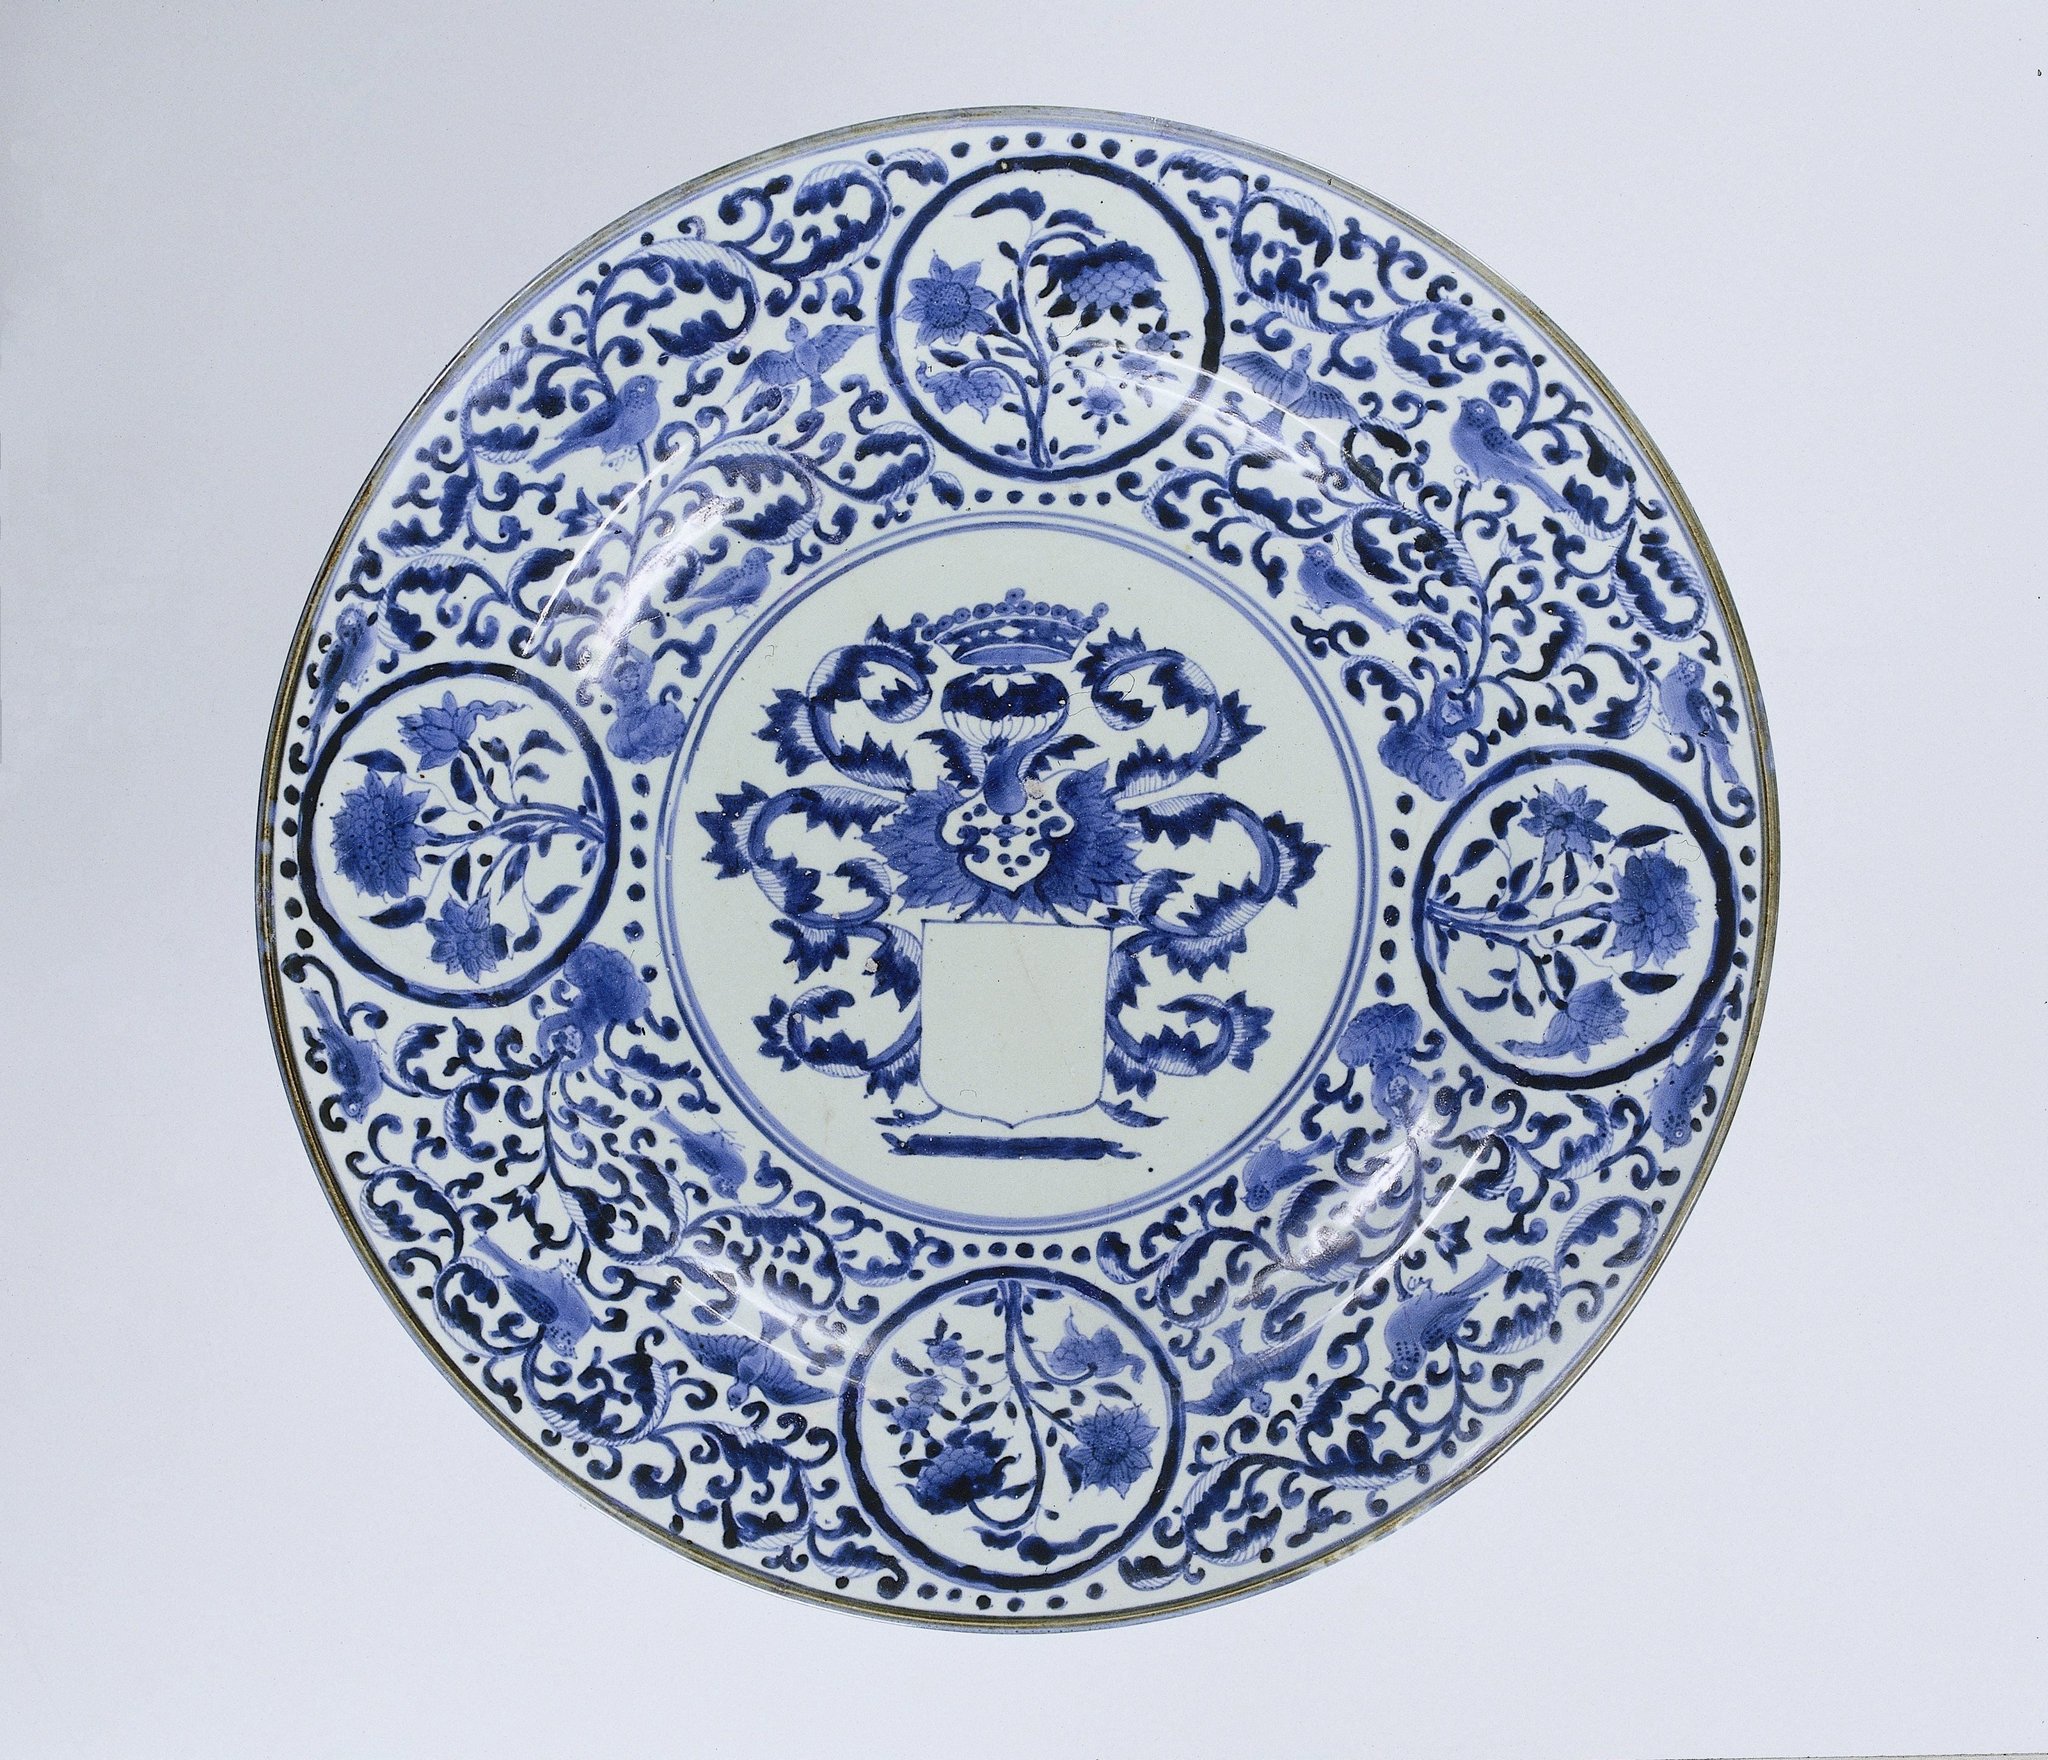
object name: platter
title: Dish with an empty coat of arms, flowering plants and scrolls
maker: Anonymous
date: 1675-1699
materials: cobalt, glaze, paint, porcelain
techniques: firing, turning, vitrification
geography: japan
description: Schotel van porselein, beschilderd in onderglazuur blauw. Op het plat in een dubbel medaillon een leeg wapenschild met als helmteken een kroon en bladranken als dekkleed. Op de wand en rand bladranken met vogels onderbroken door vier medaillons met bloeiende planten. Onder twee medaillons tweemaal een mensfiguur die de tak van de bloemrank boven zijn hoofd vasthoudt. Schotel is gebroken geweest; zestien proenen op de onderzijde. Europese voorstelling in blauw-wit.